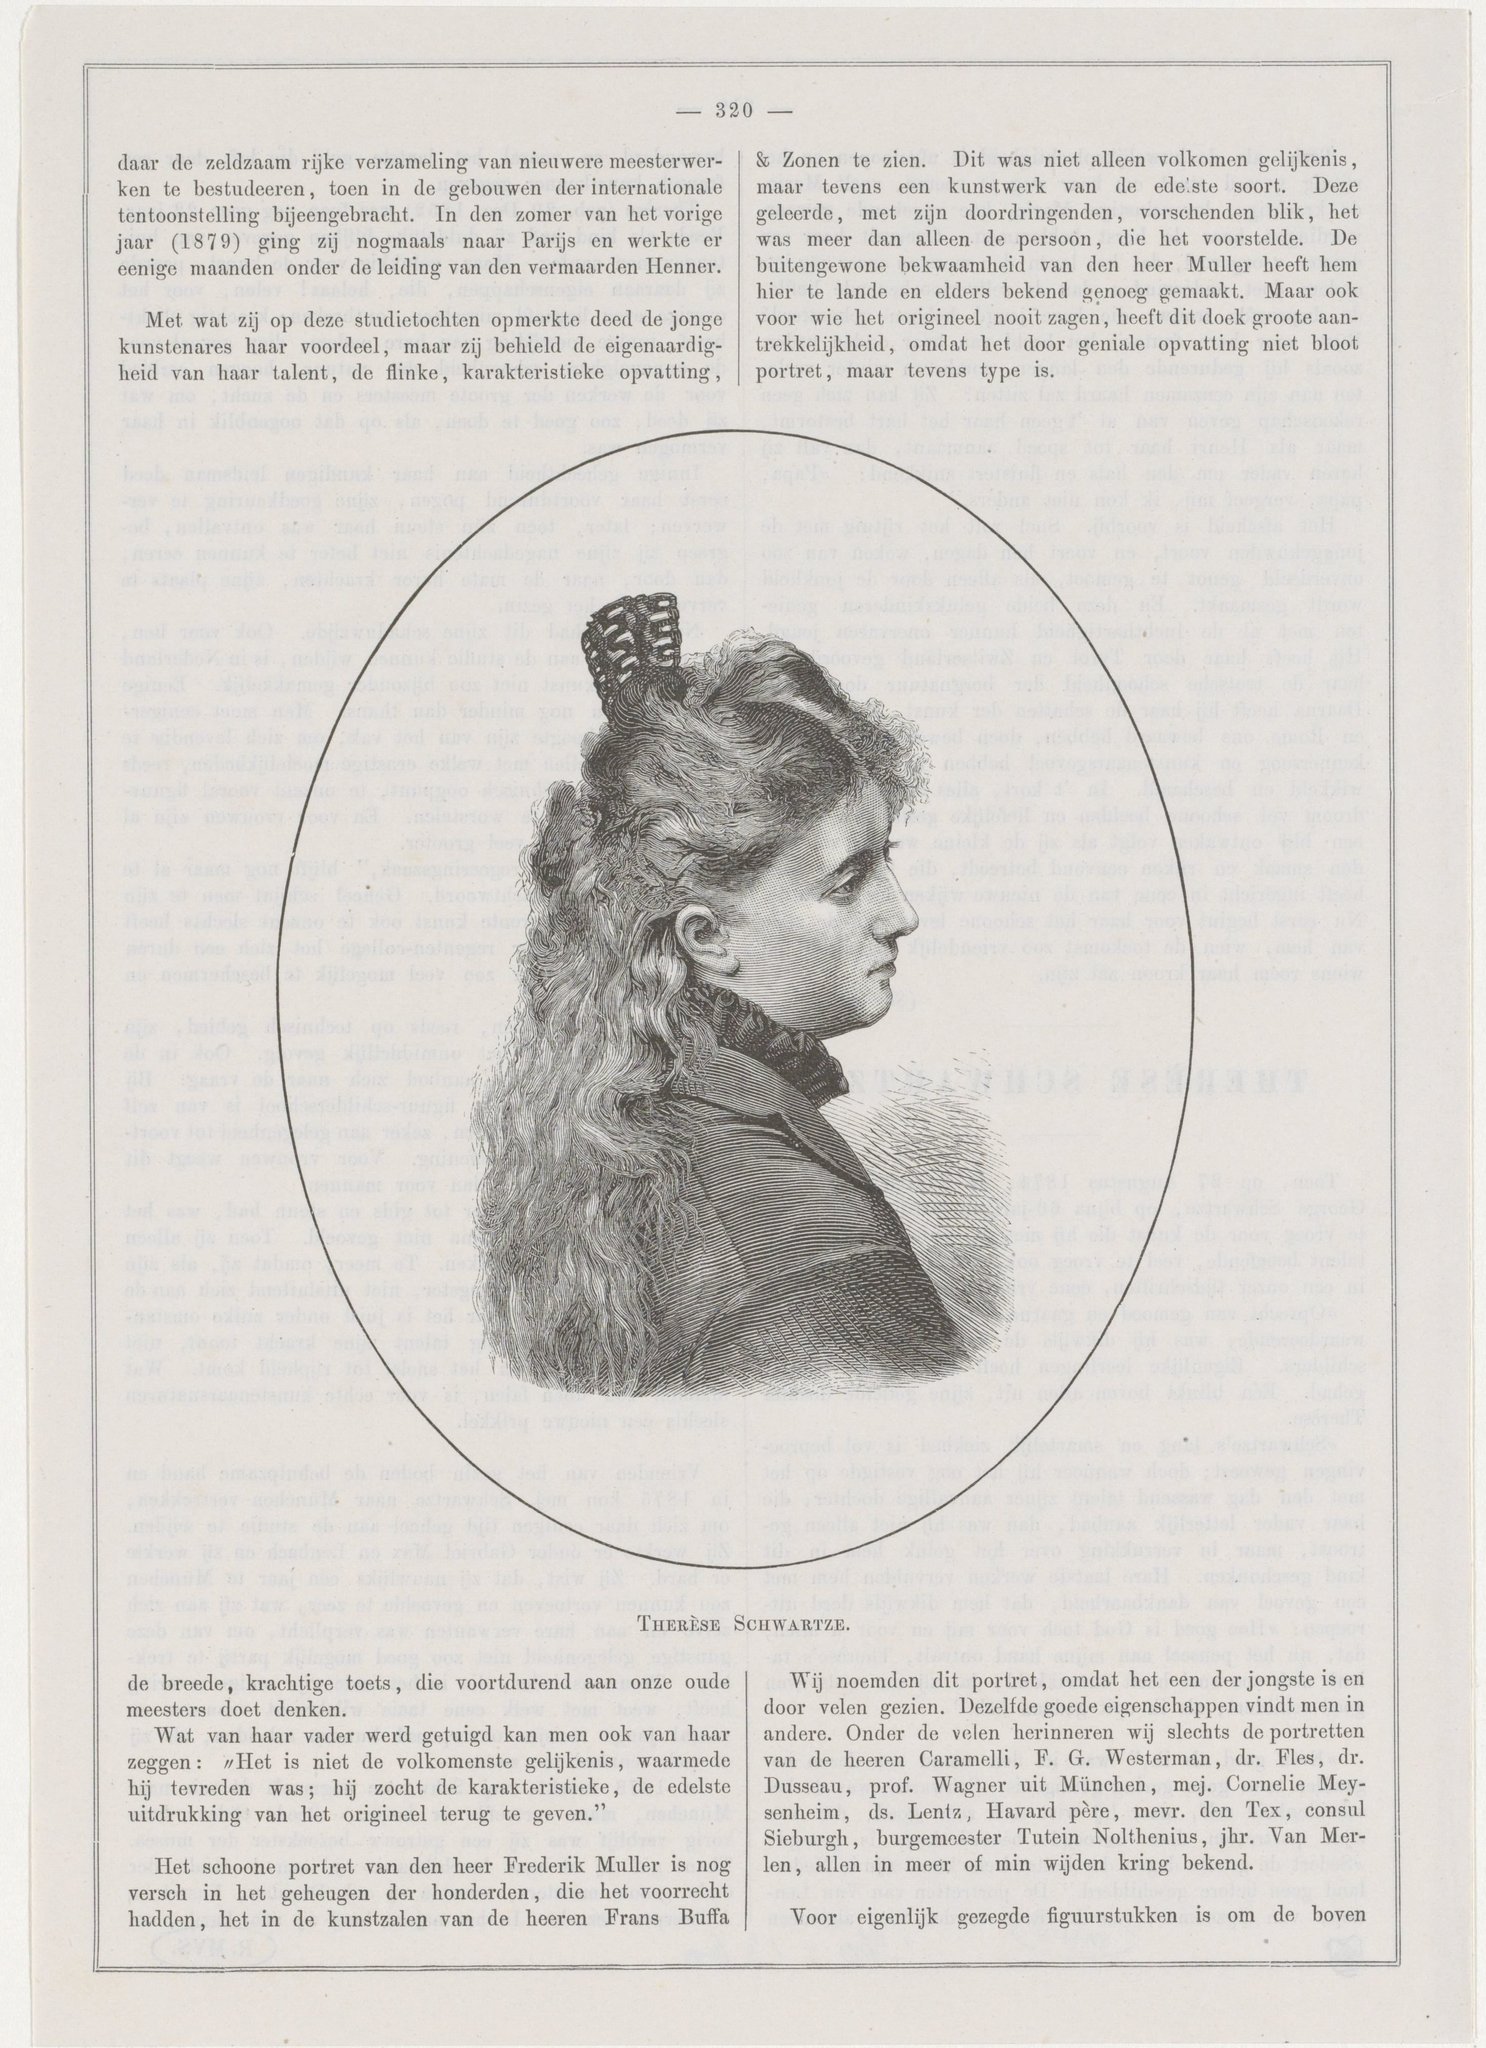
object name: print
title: Portret van Thérèse Schwartze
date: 1880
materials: paper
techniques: letterpress printing, engraving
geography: paris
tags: amsterdam, painter, print maker, draughtsman, thérèse schwartze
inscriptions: collector's mark: Lugt 2228, collector's mark: Lugt 2760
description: Portret van Thérèse Schwartze in een ovaal. In de ondermarge haar naam.